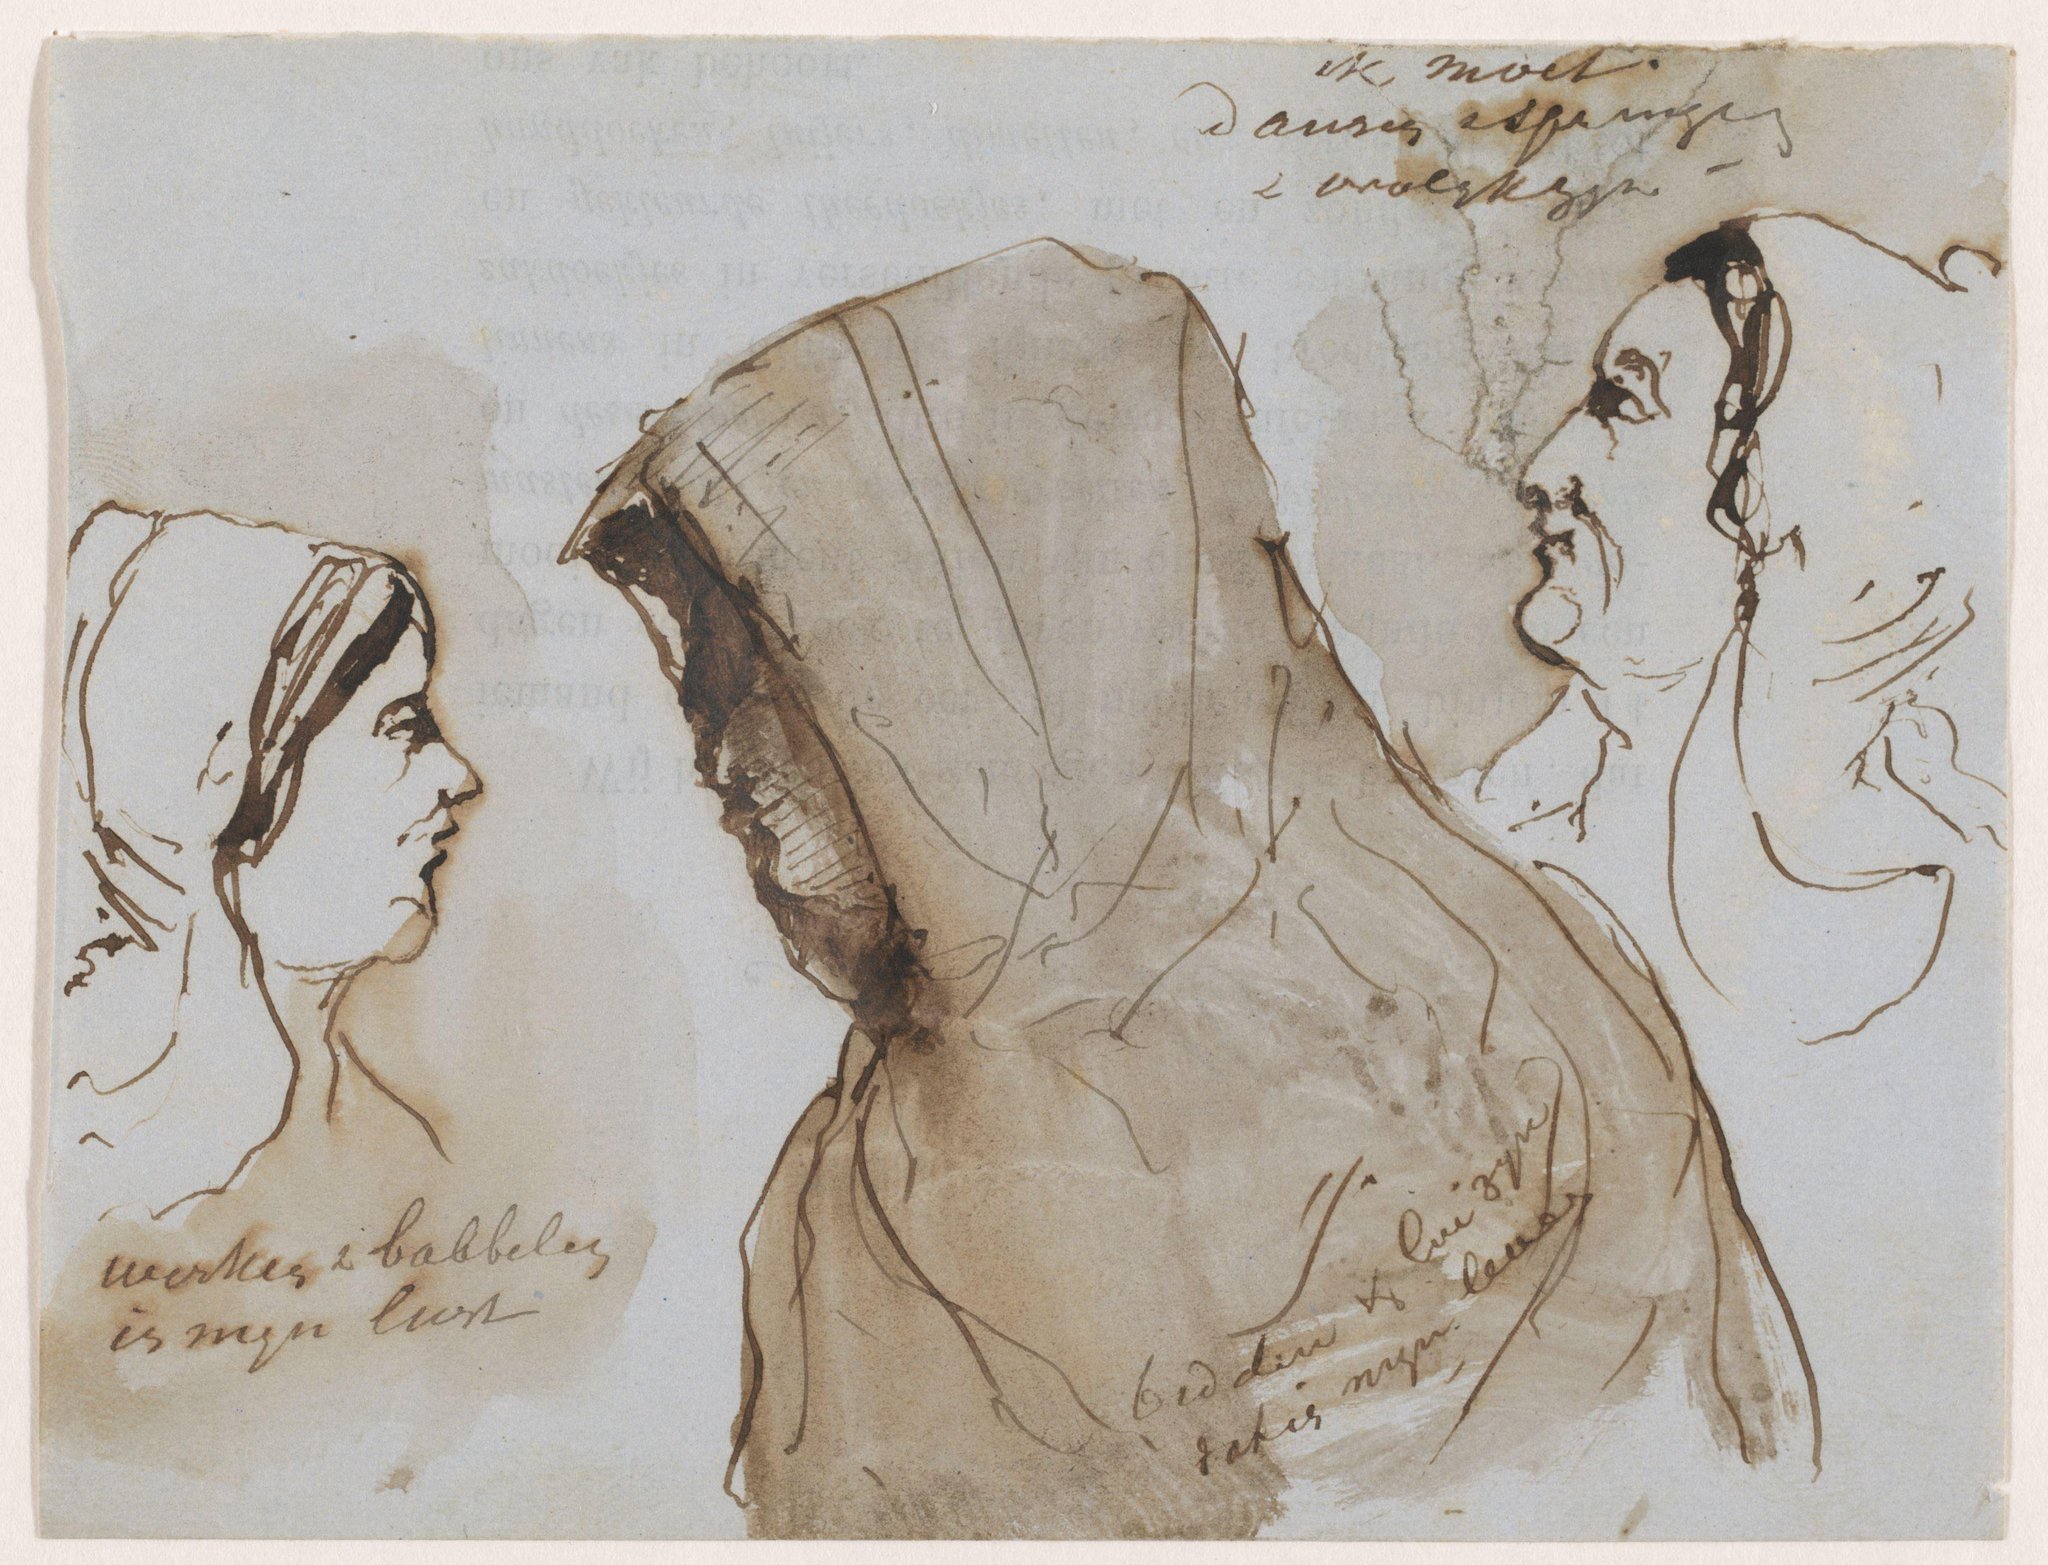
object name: drawing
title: Twee vrouwen en een persoon met capuchon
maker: johannes tavenraat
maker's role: draughtsman, painter, print maker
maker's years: 1809-1881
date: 1840-1880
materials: ink, paper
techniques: brush, pen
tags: head-gear: hood, monk(s), friar(s)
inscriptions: collector's mark: Lugt 2228, annotation: ‘werken & babbelen is mijn lust ...’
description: Twee vrouwen en een persoon met capuchon, mogelijk een monnik. Getekend op de achterzijde van een fragment van een drukwerk.